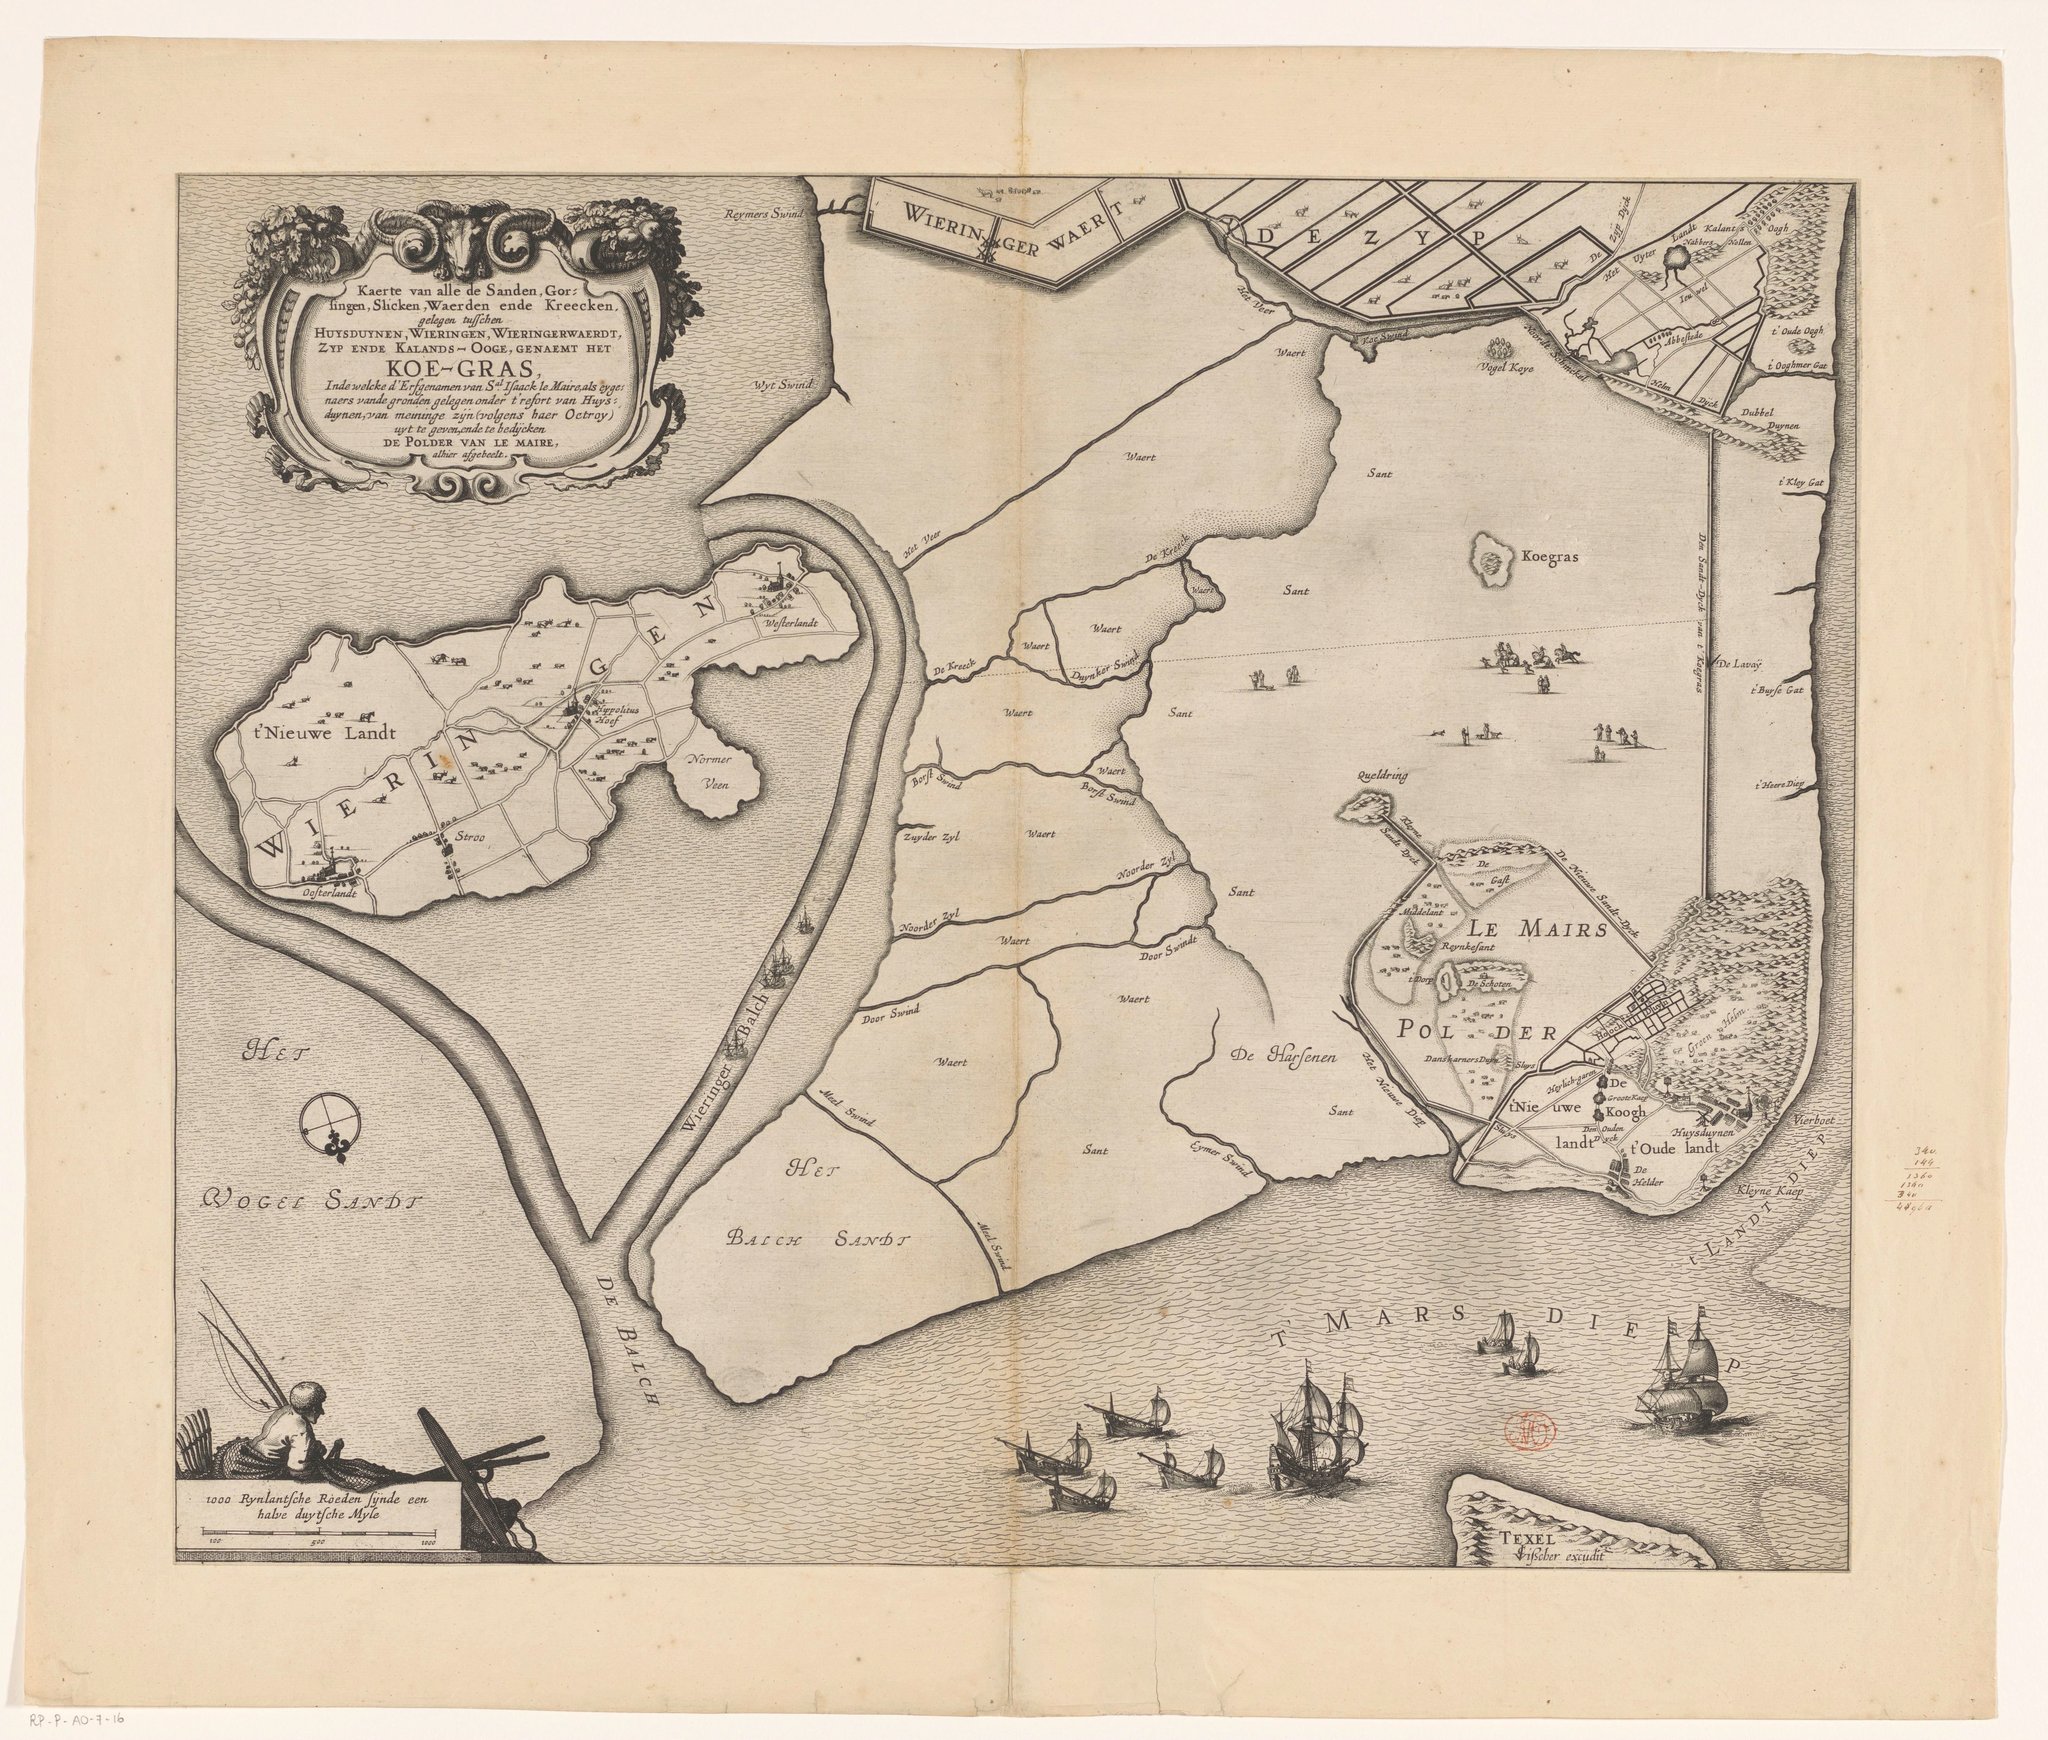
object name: print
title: Kaart van de polder het Koegras met daarop de Le Maires polder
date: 1640-1652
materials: paper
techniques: engraving, etching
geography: amsterdam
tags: maps of separate countries or regions, polder, reclaimed land, fisherman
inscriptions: collector's mark: Lugt 195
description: Linksboven de titelcartouche, linksonder een schaalstok: 1000 Rynlantsche roeden sijnde een halve duytsche myle. Daarboven een visser.